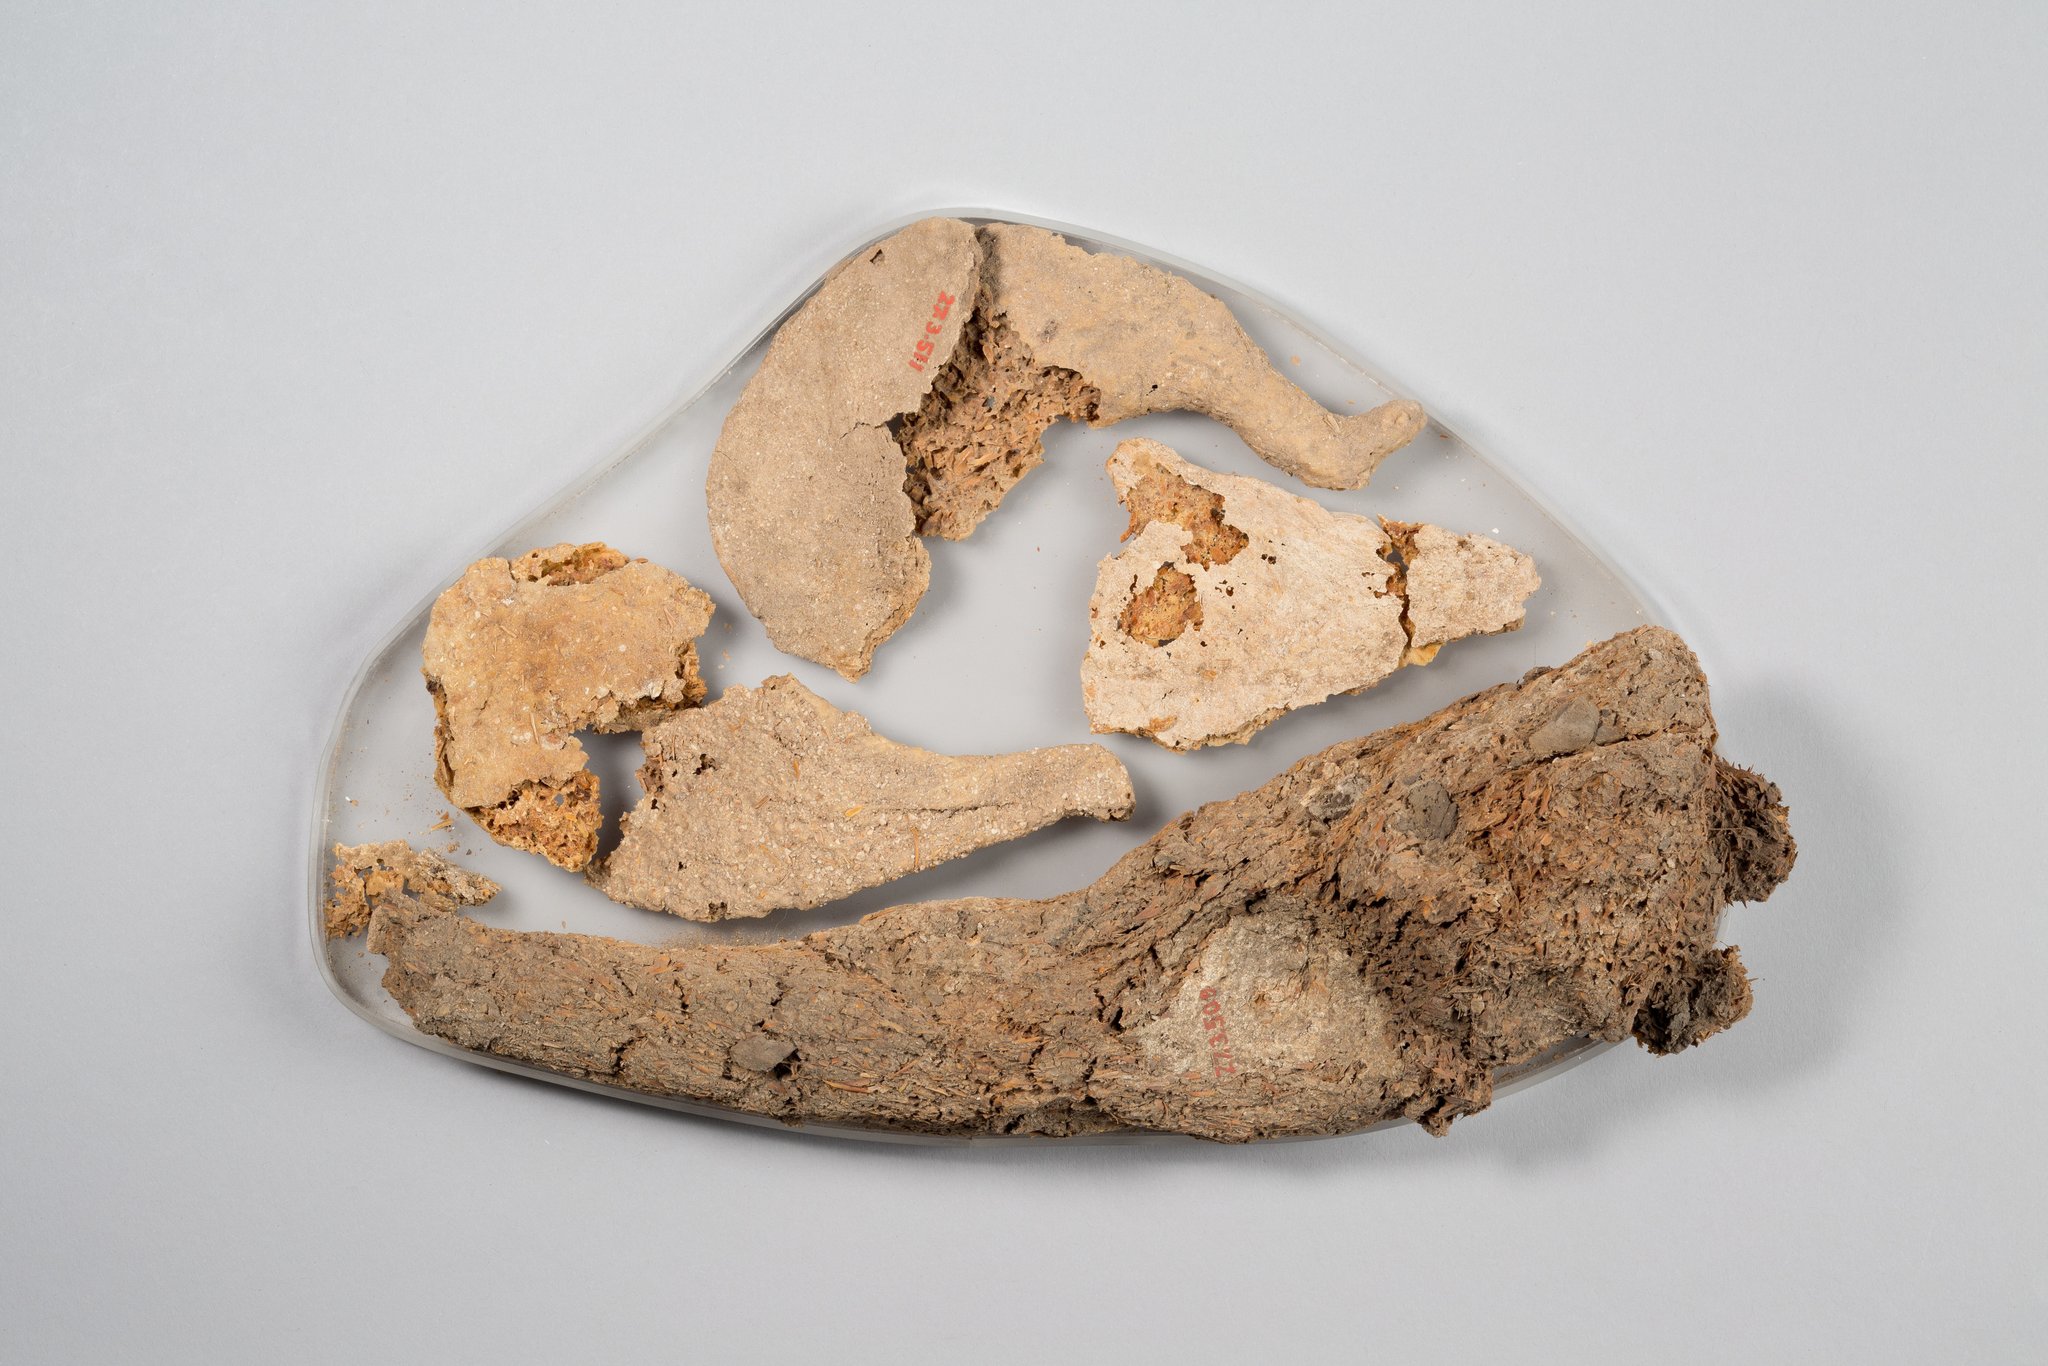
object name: food, bread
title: Bread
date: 1479-1458 BCE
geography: egypt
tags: bread